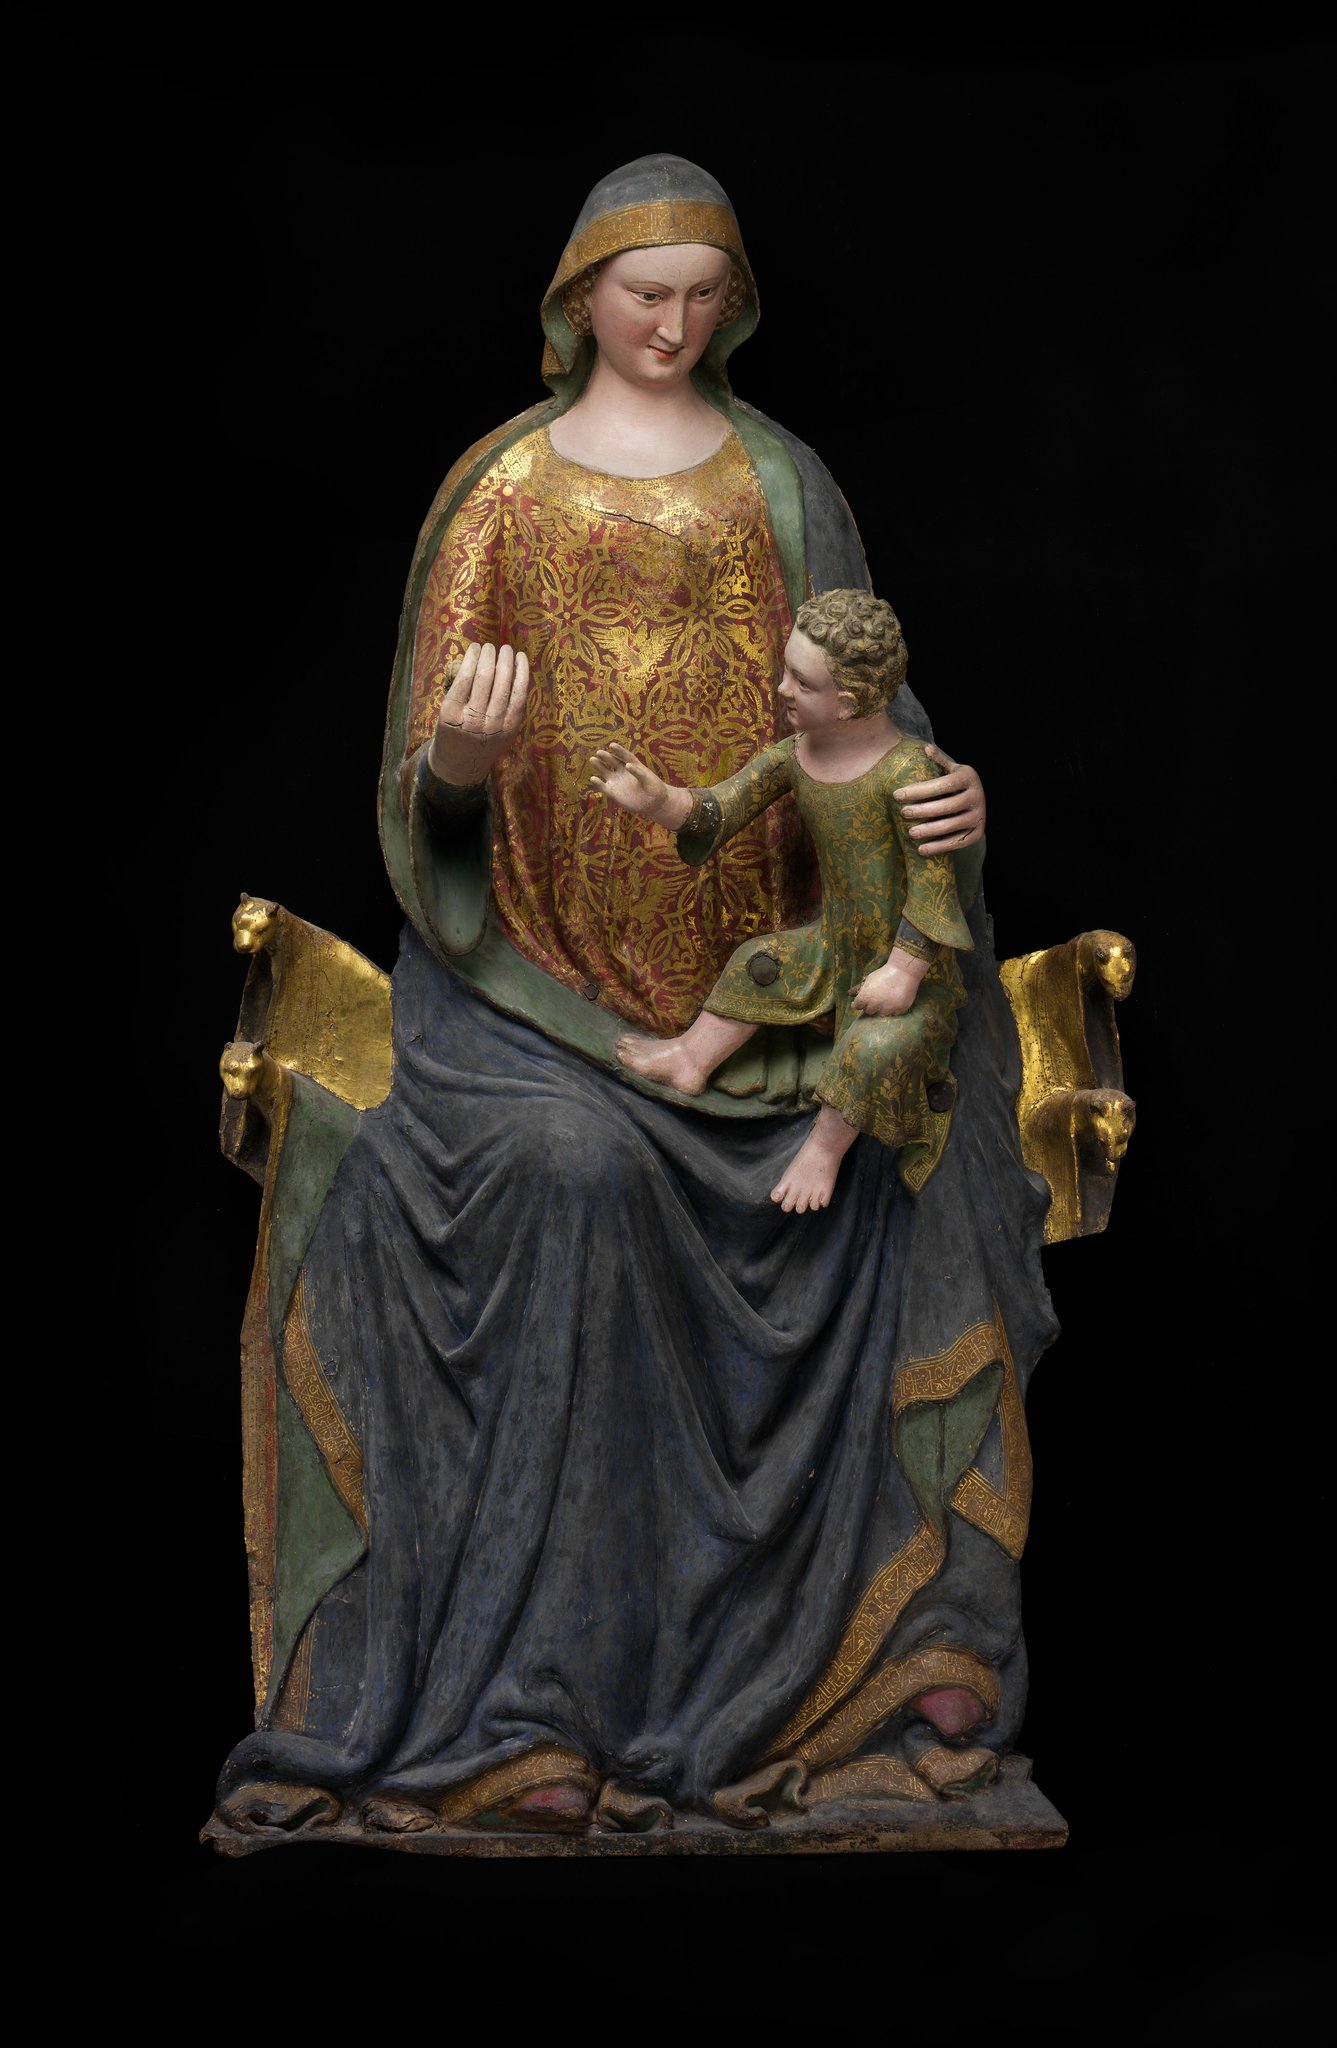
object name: statue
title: Enthroned Virgin and Child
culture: italian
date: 1334-1366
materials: canvas, gesso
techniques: painting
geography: central italy